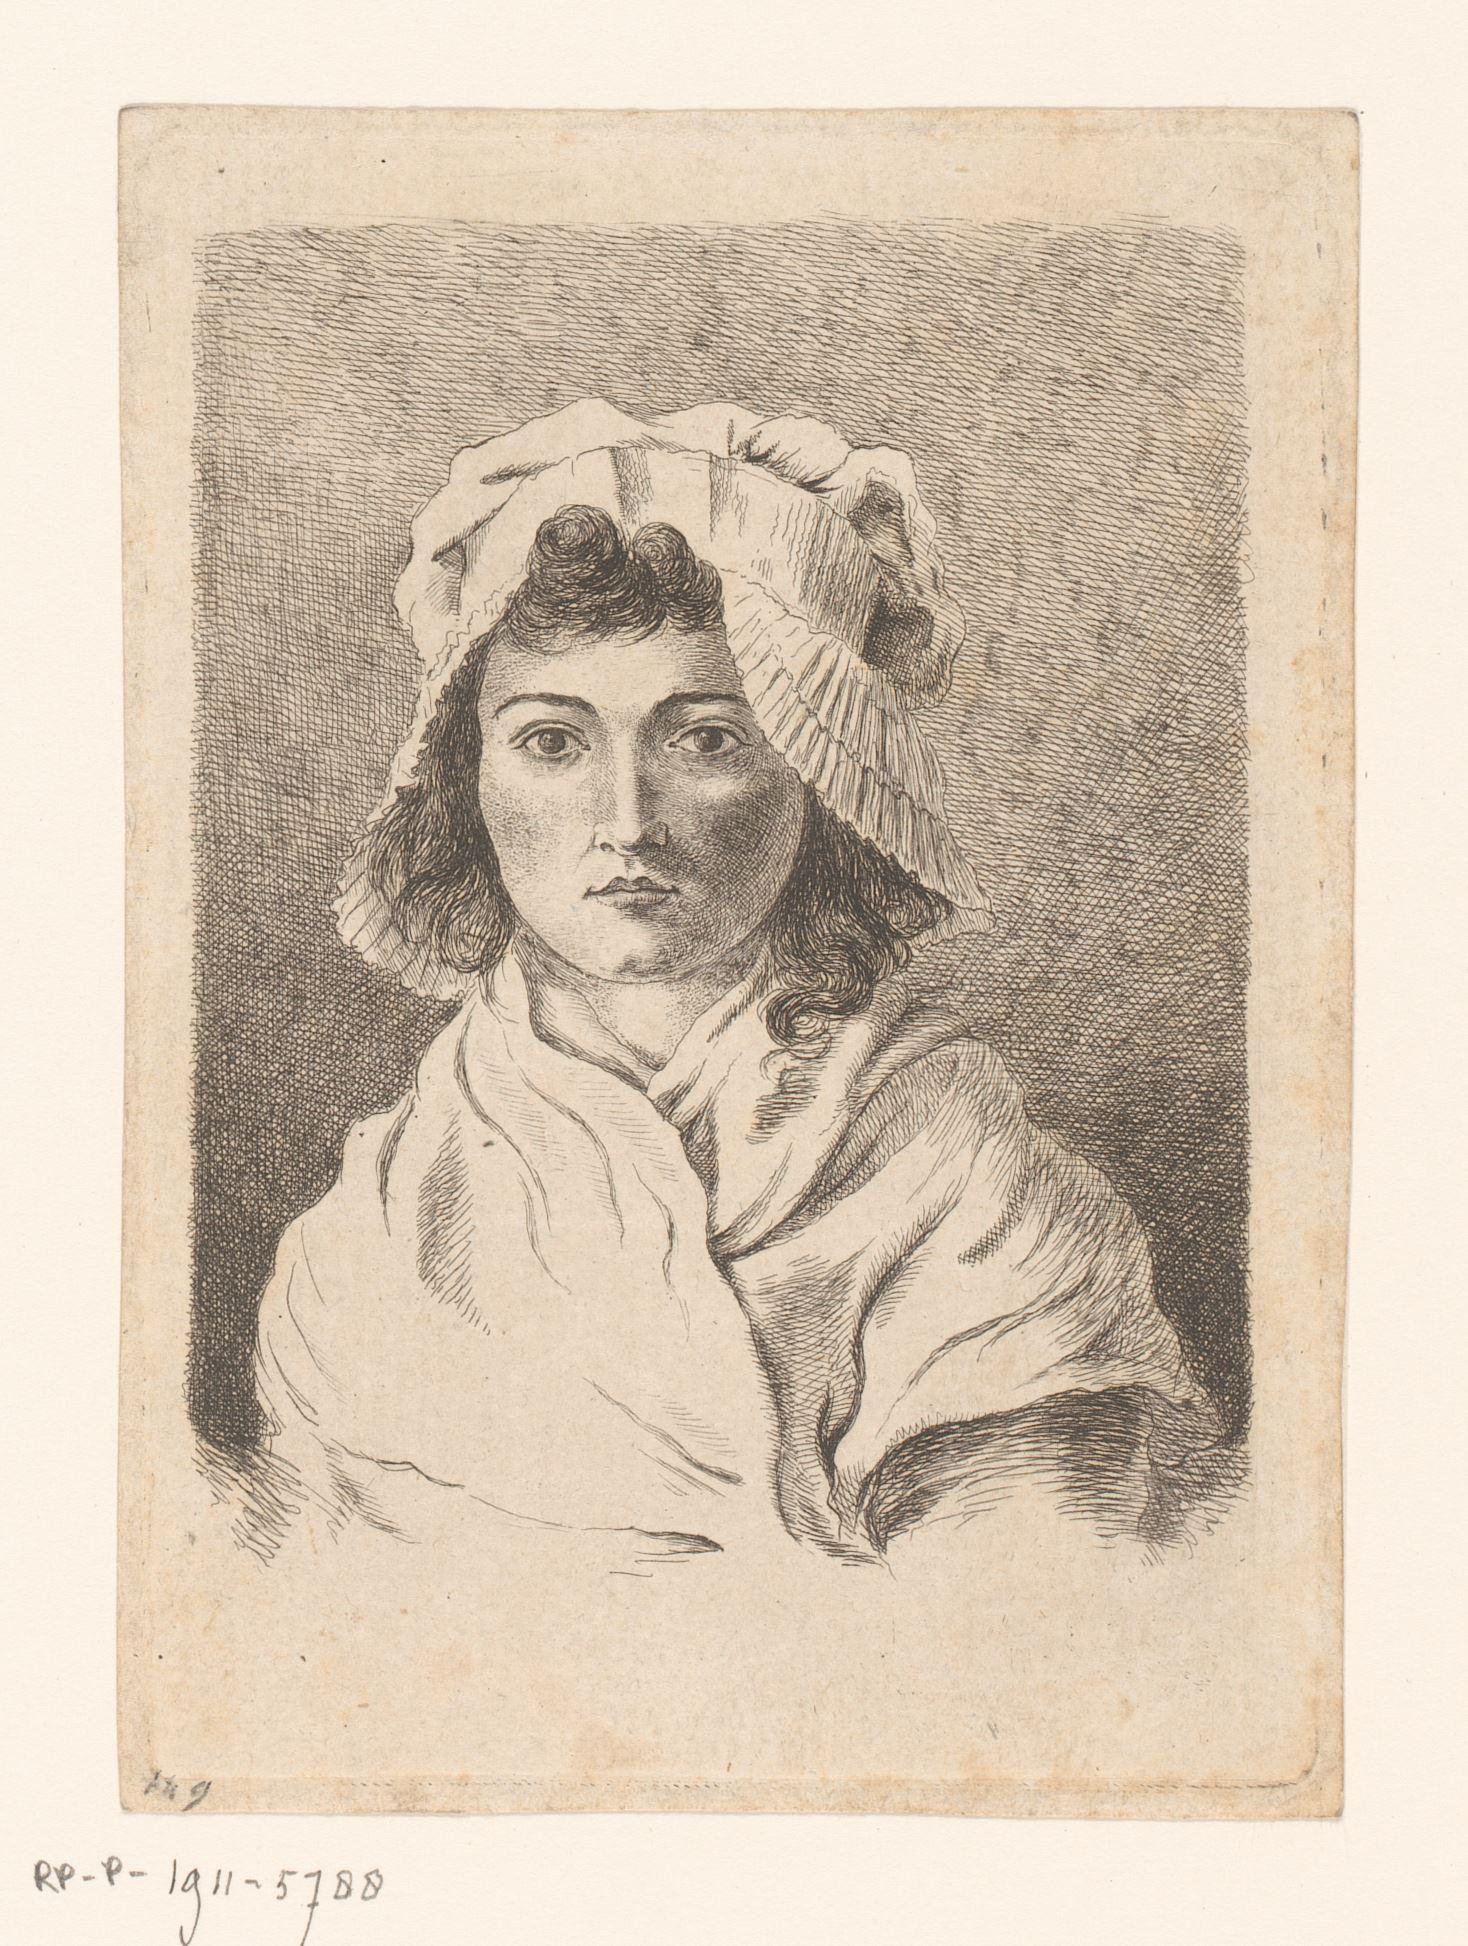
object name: print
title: Mogelijk zelfportret als vrouw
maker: sauveur legros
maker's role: print maker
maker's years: 1754-1834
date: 1764-1834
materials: paper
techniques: etching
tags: print maker, sauveur legros, man dressed as woman, travesty, historical persons, head-gear: cap (+ women's clothes), portrait, self-portrait of artist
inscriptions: collector's mark: Lugt 2228